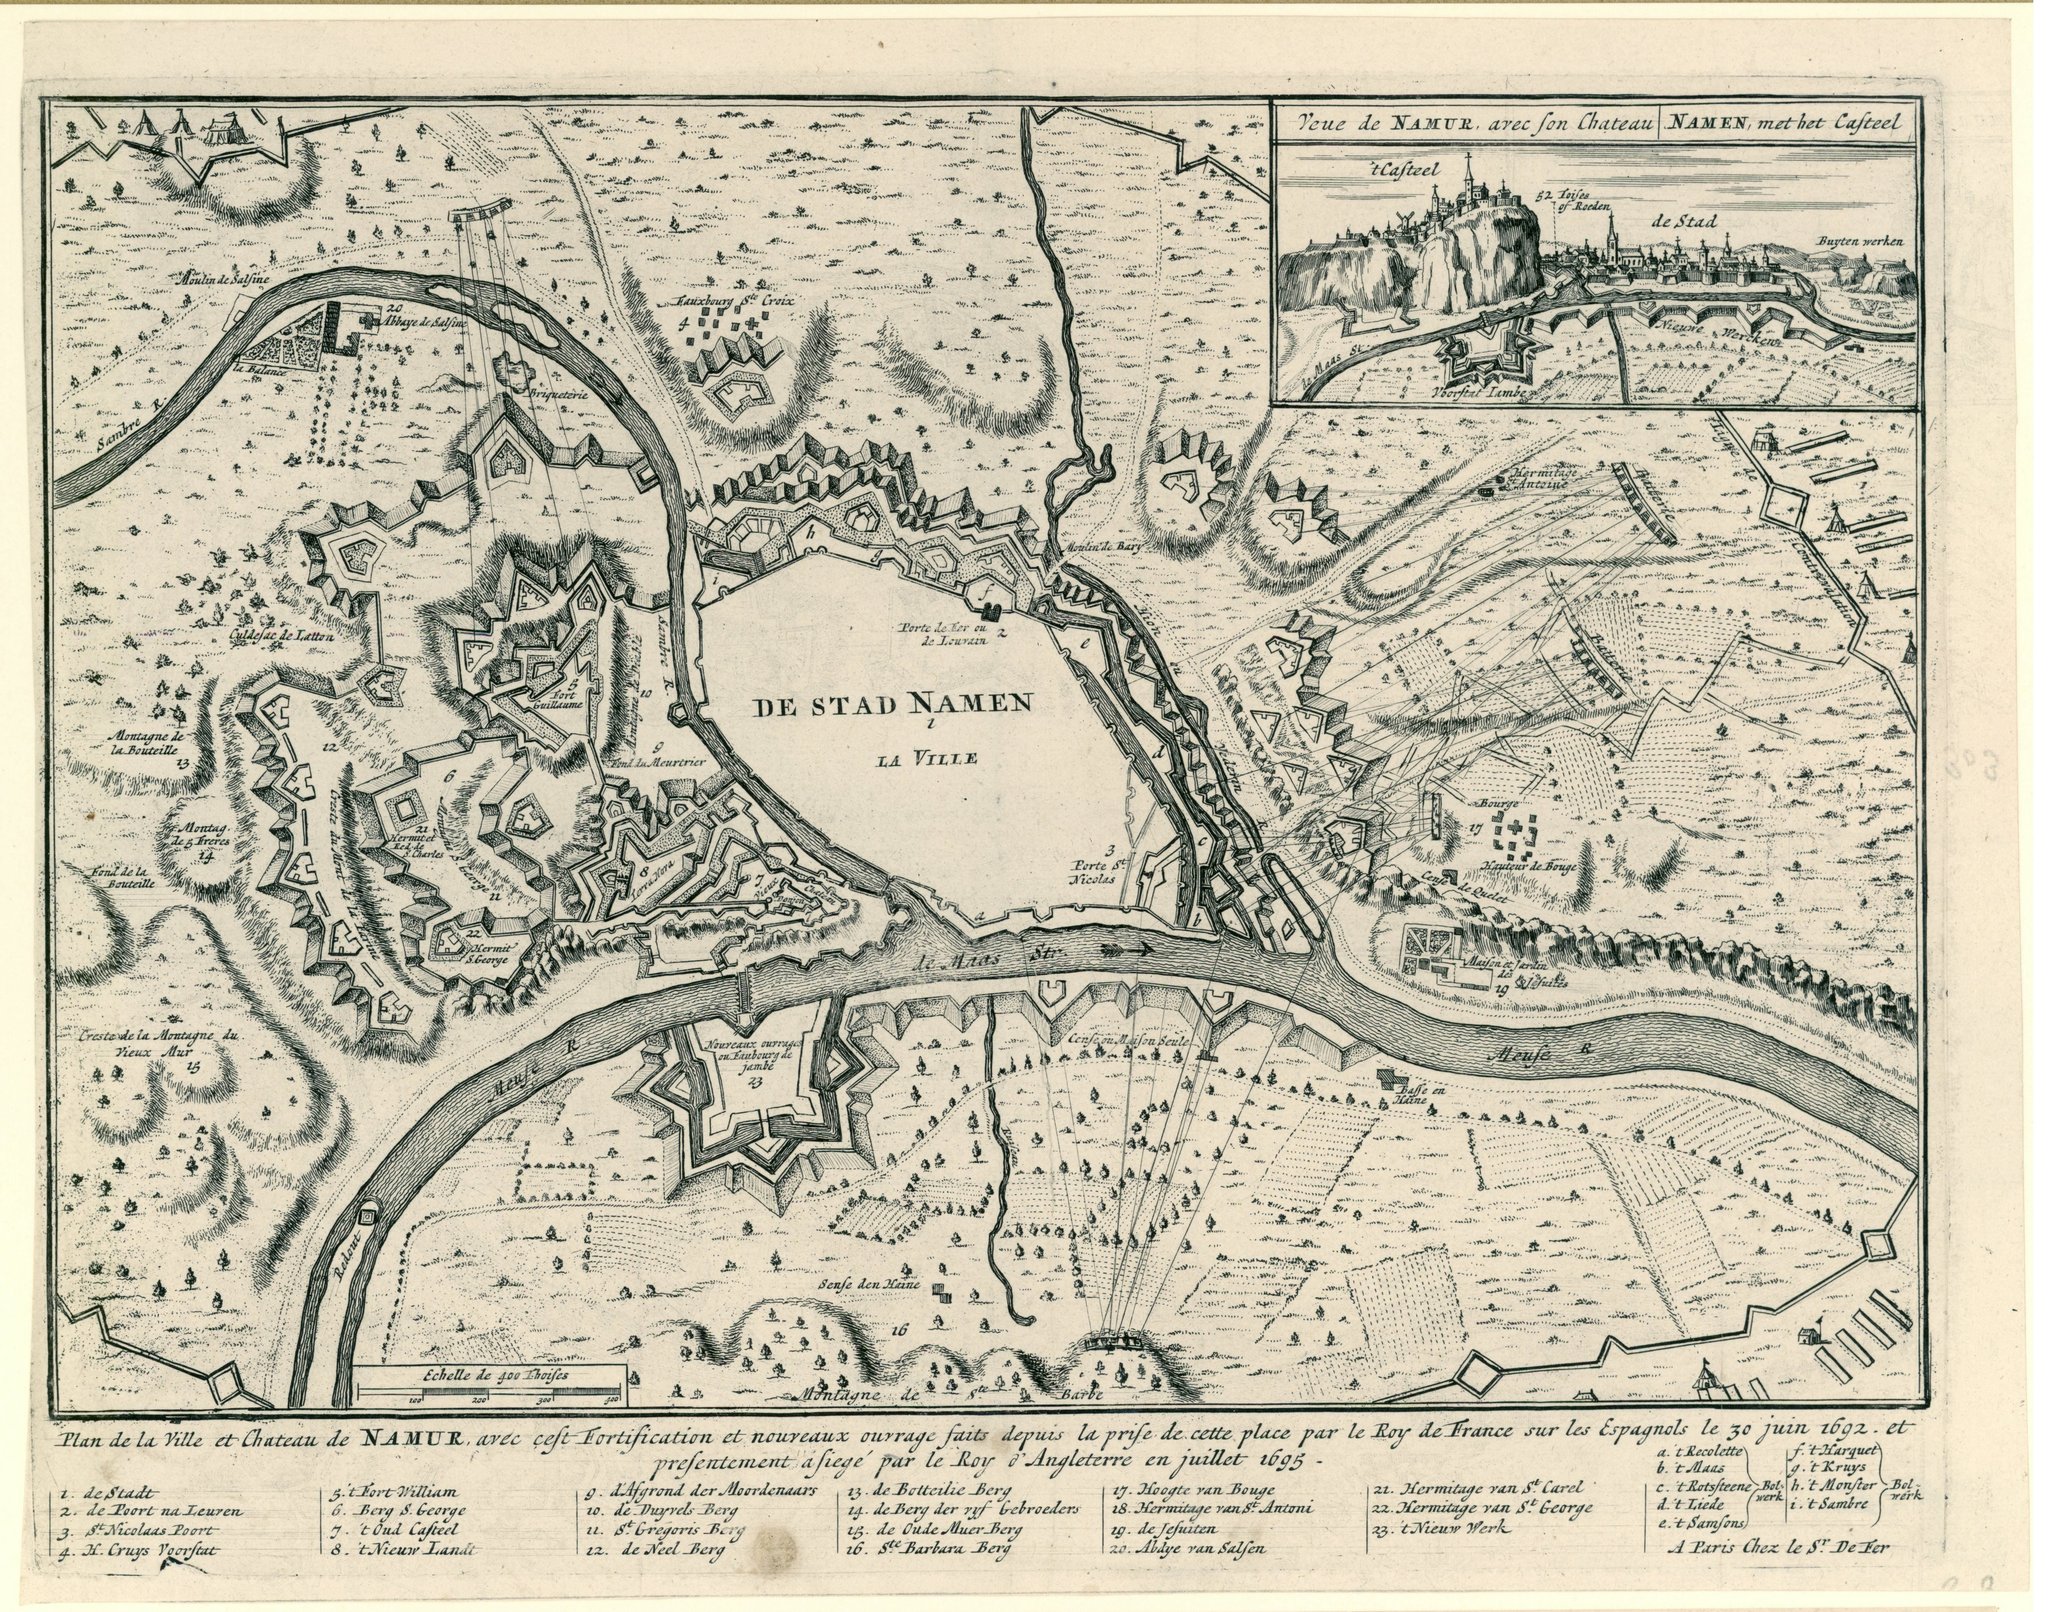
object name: print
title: Beleg van Namen, 1695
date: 1695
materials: paper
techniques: etching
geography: france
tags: the hague, william iii (prince of orange and king of england, scotland, and ireland), siege, position war, maps of cities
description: Plan van Namen en de directe omgeving met de posities van de belegerende geallieerde troepen en de schietlijnen van de batterijen. Rechts boven een inzet met een klein gezicht op de stad. Onder de prent een verklaring van de cijfers in het Nederlands.